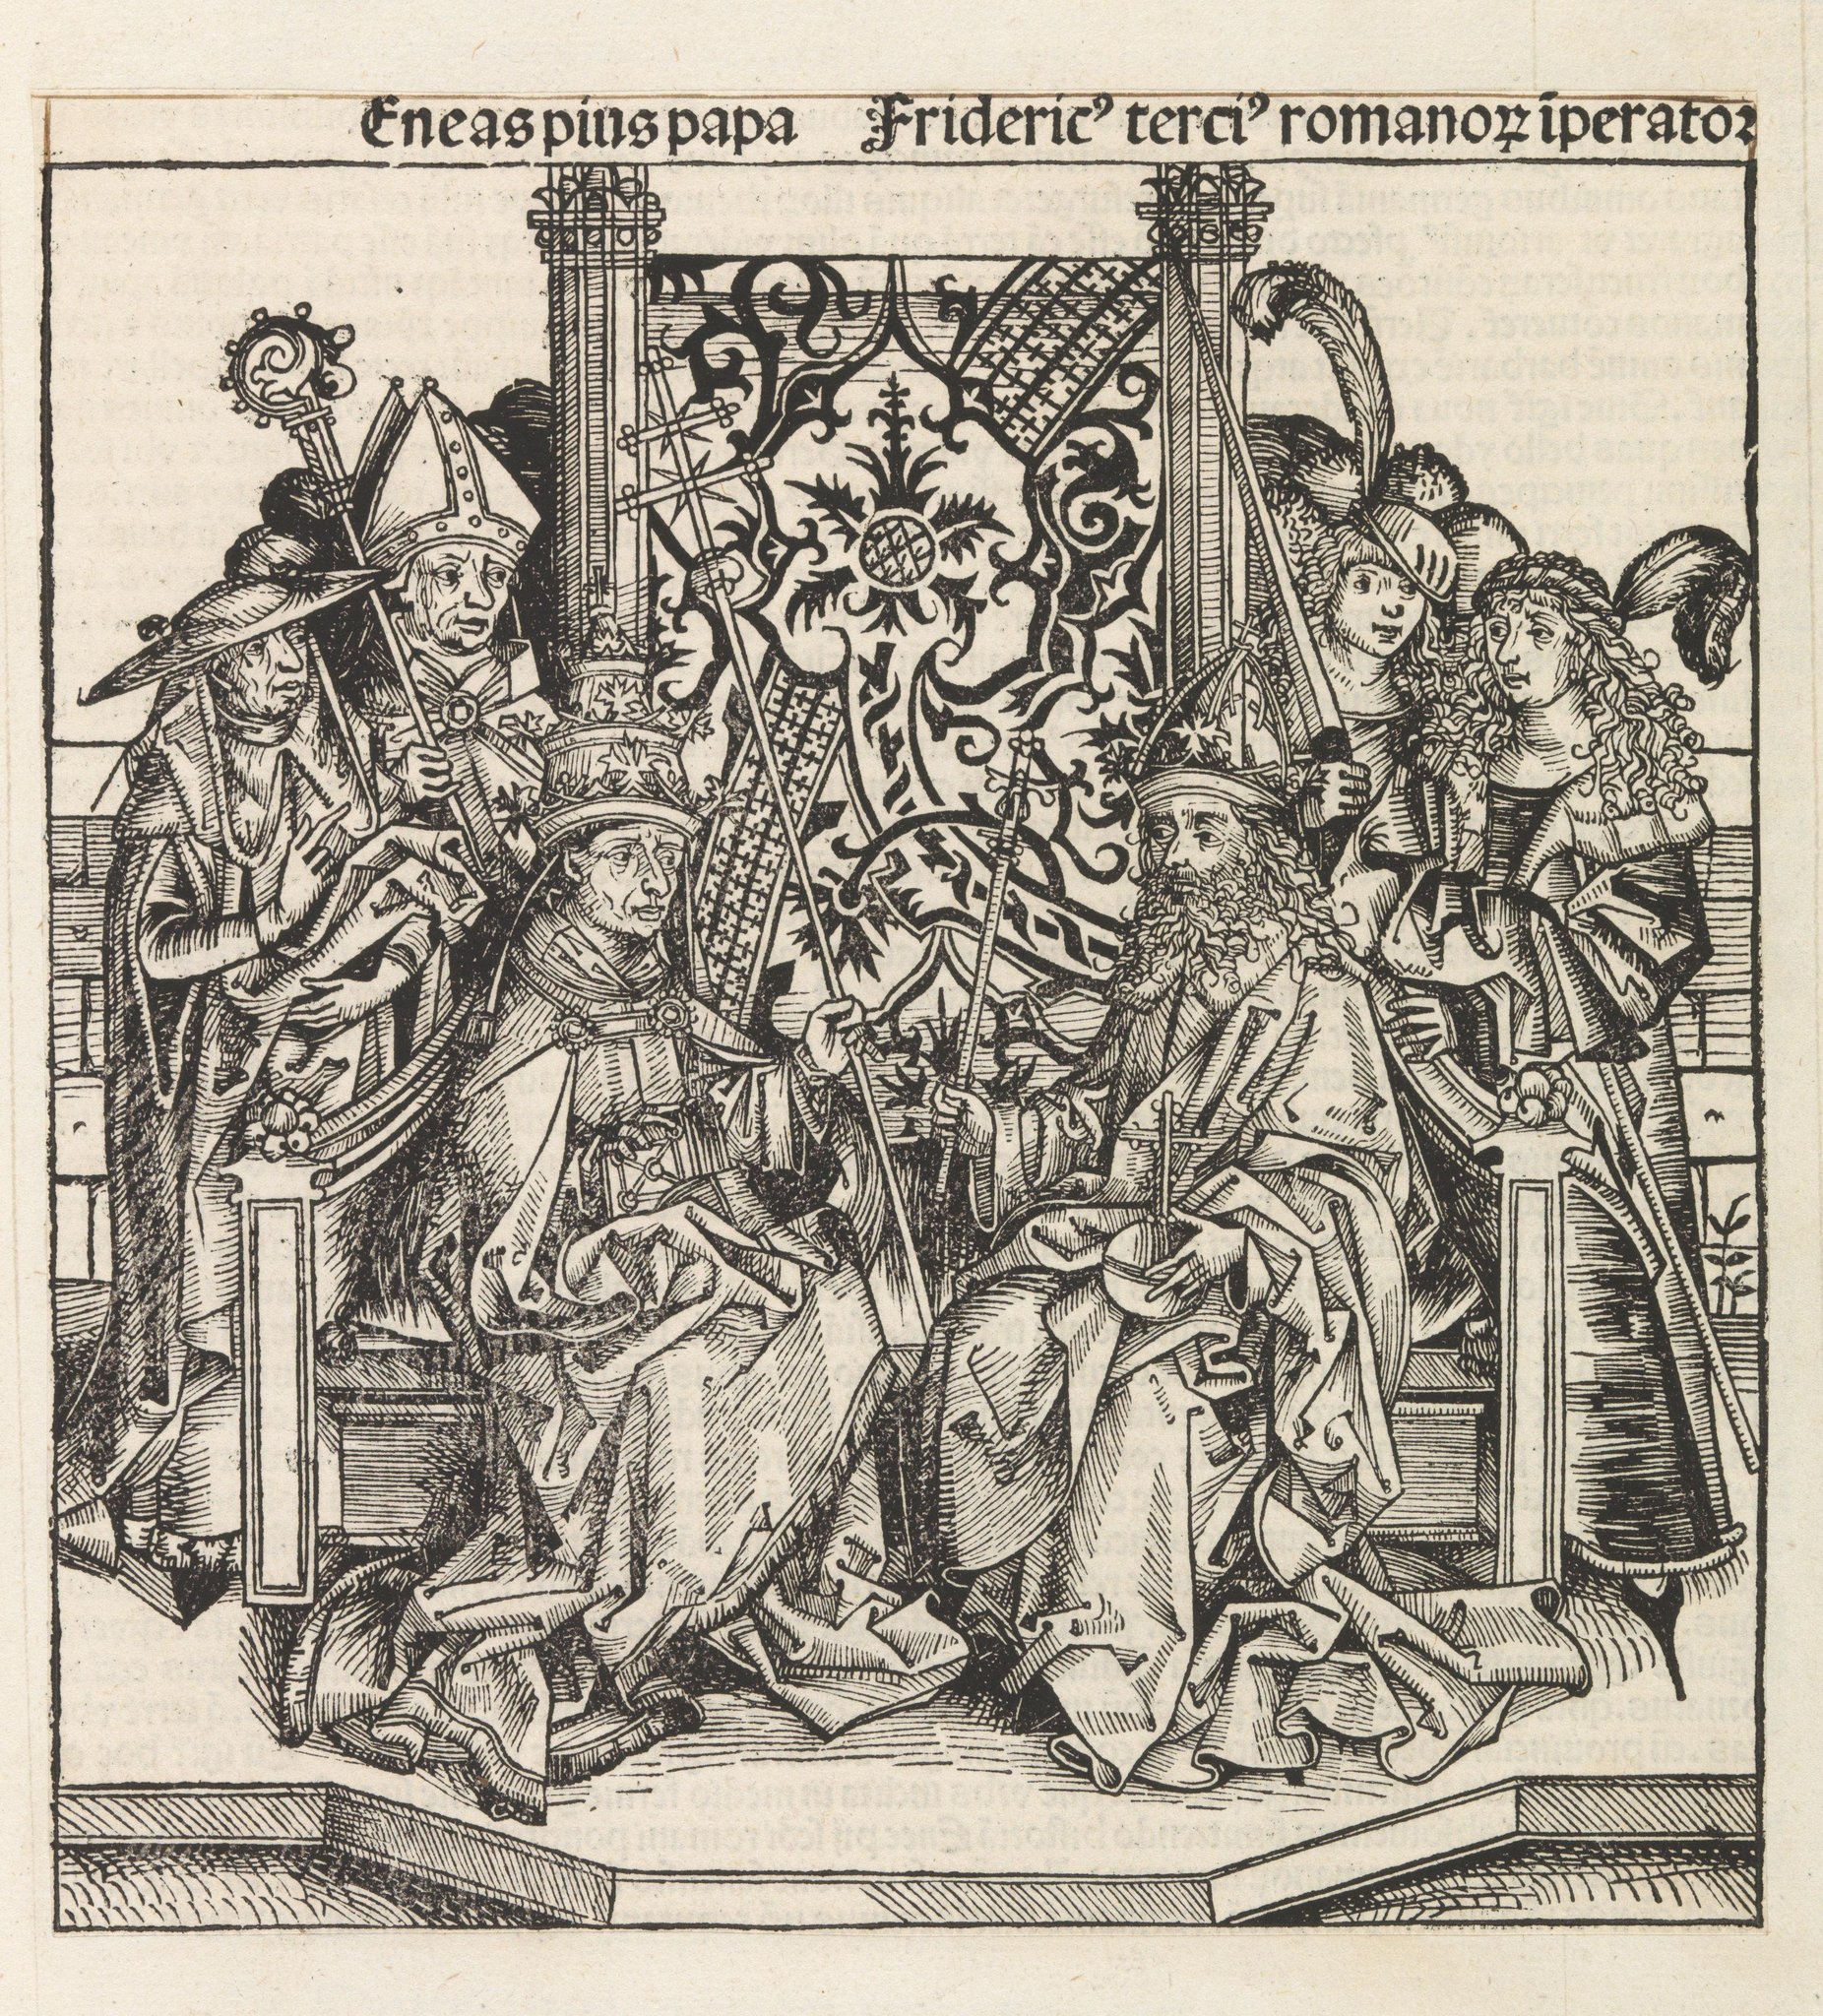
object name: album leaf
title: Paus Pius II en keizer Frederik III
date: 1493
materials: paper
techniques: letterpress printing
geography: nuremberg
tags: archbishop, bishop, etc. (roman catholic), emperor, pope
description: De houtsnede wordt gebruikt als boekillustratie in de Liber Chronicarum (of Neurenbergkroniek) van Hartmann Schedel, verschenen in het Latijn en Duits in 1493. Zie de Latijnse uitgave, folio 268v.